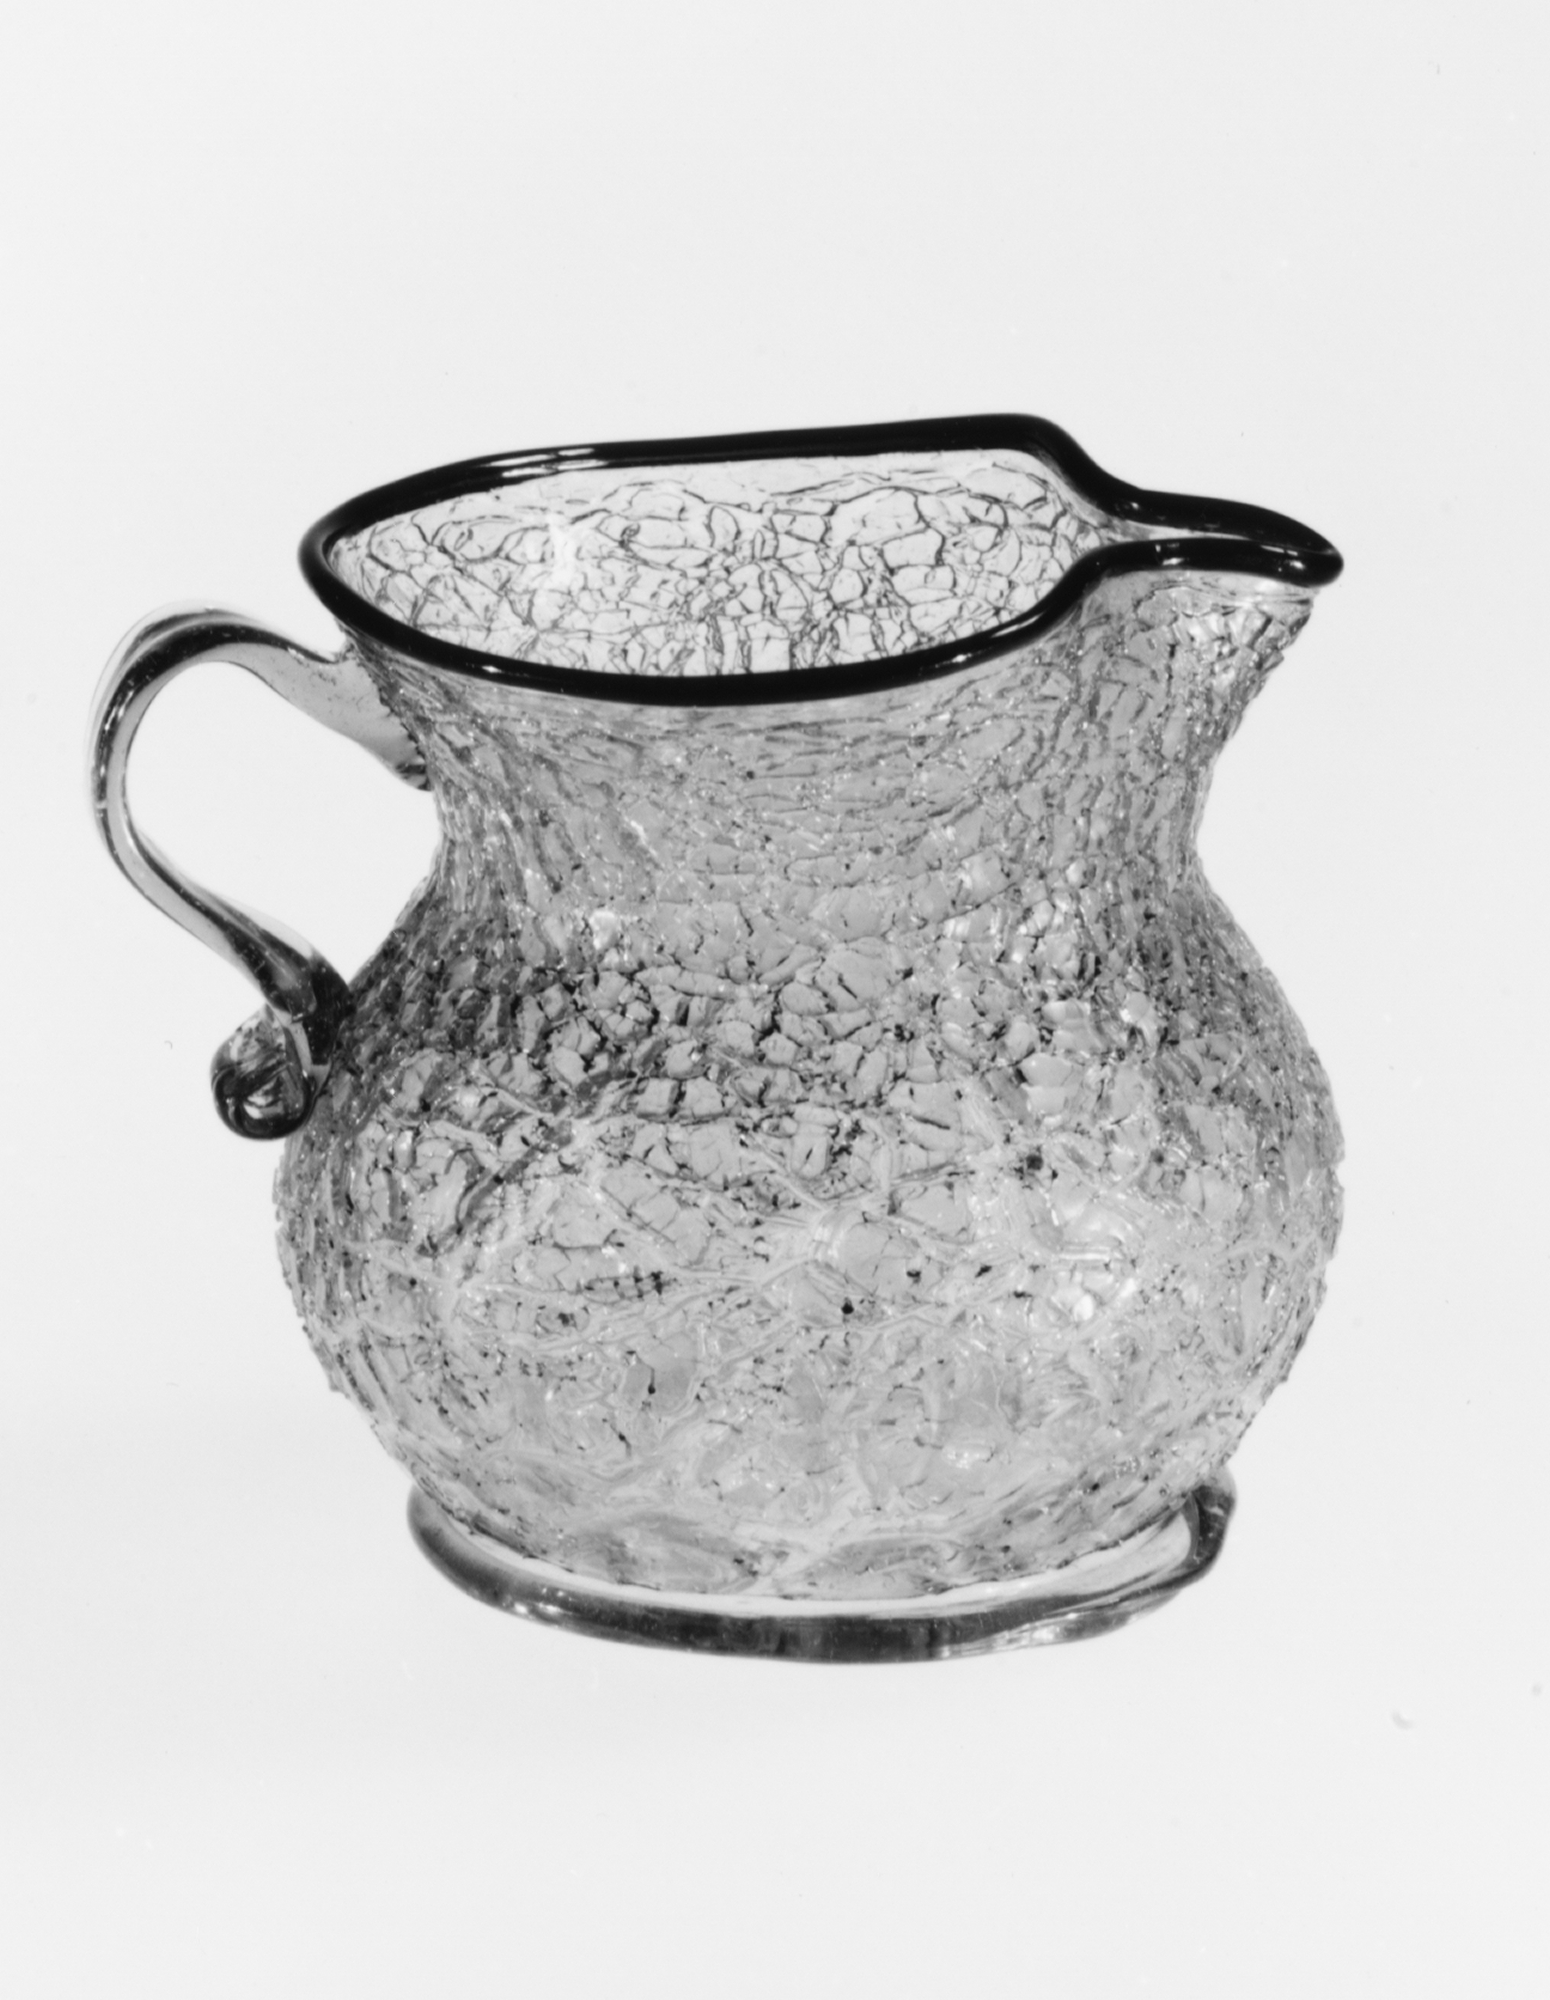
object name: pitcher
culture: italian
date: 1601-1633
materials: glass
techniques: glassblowing